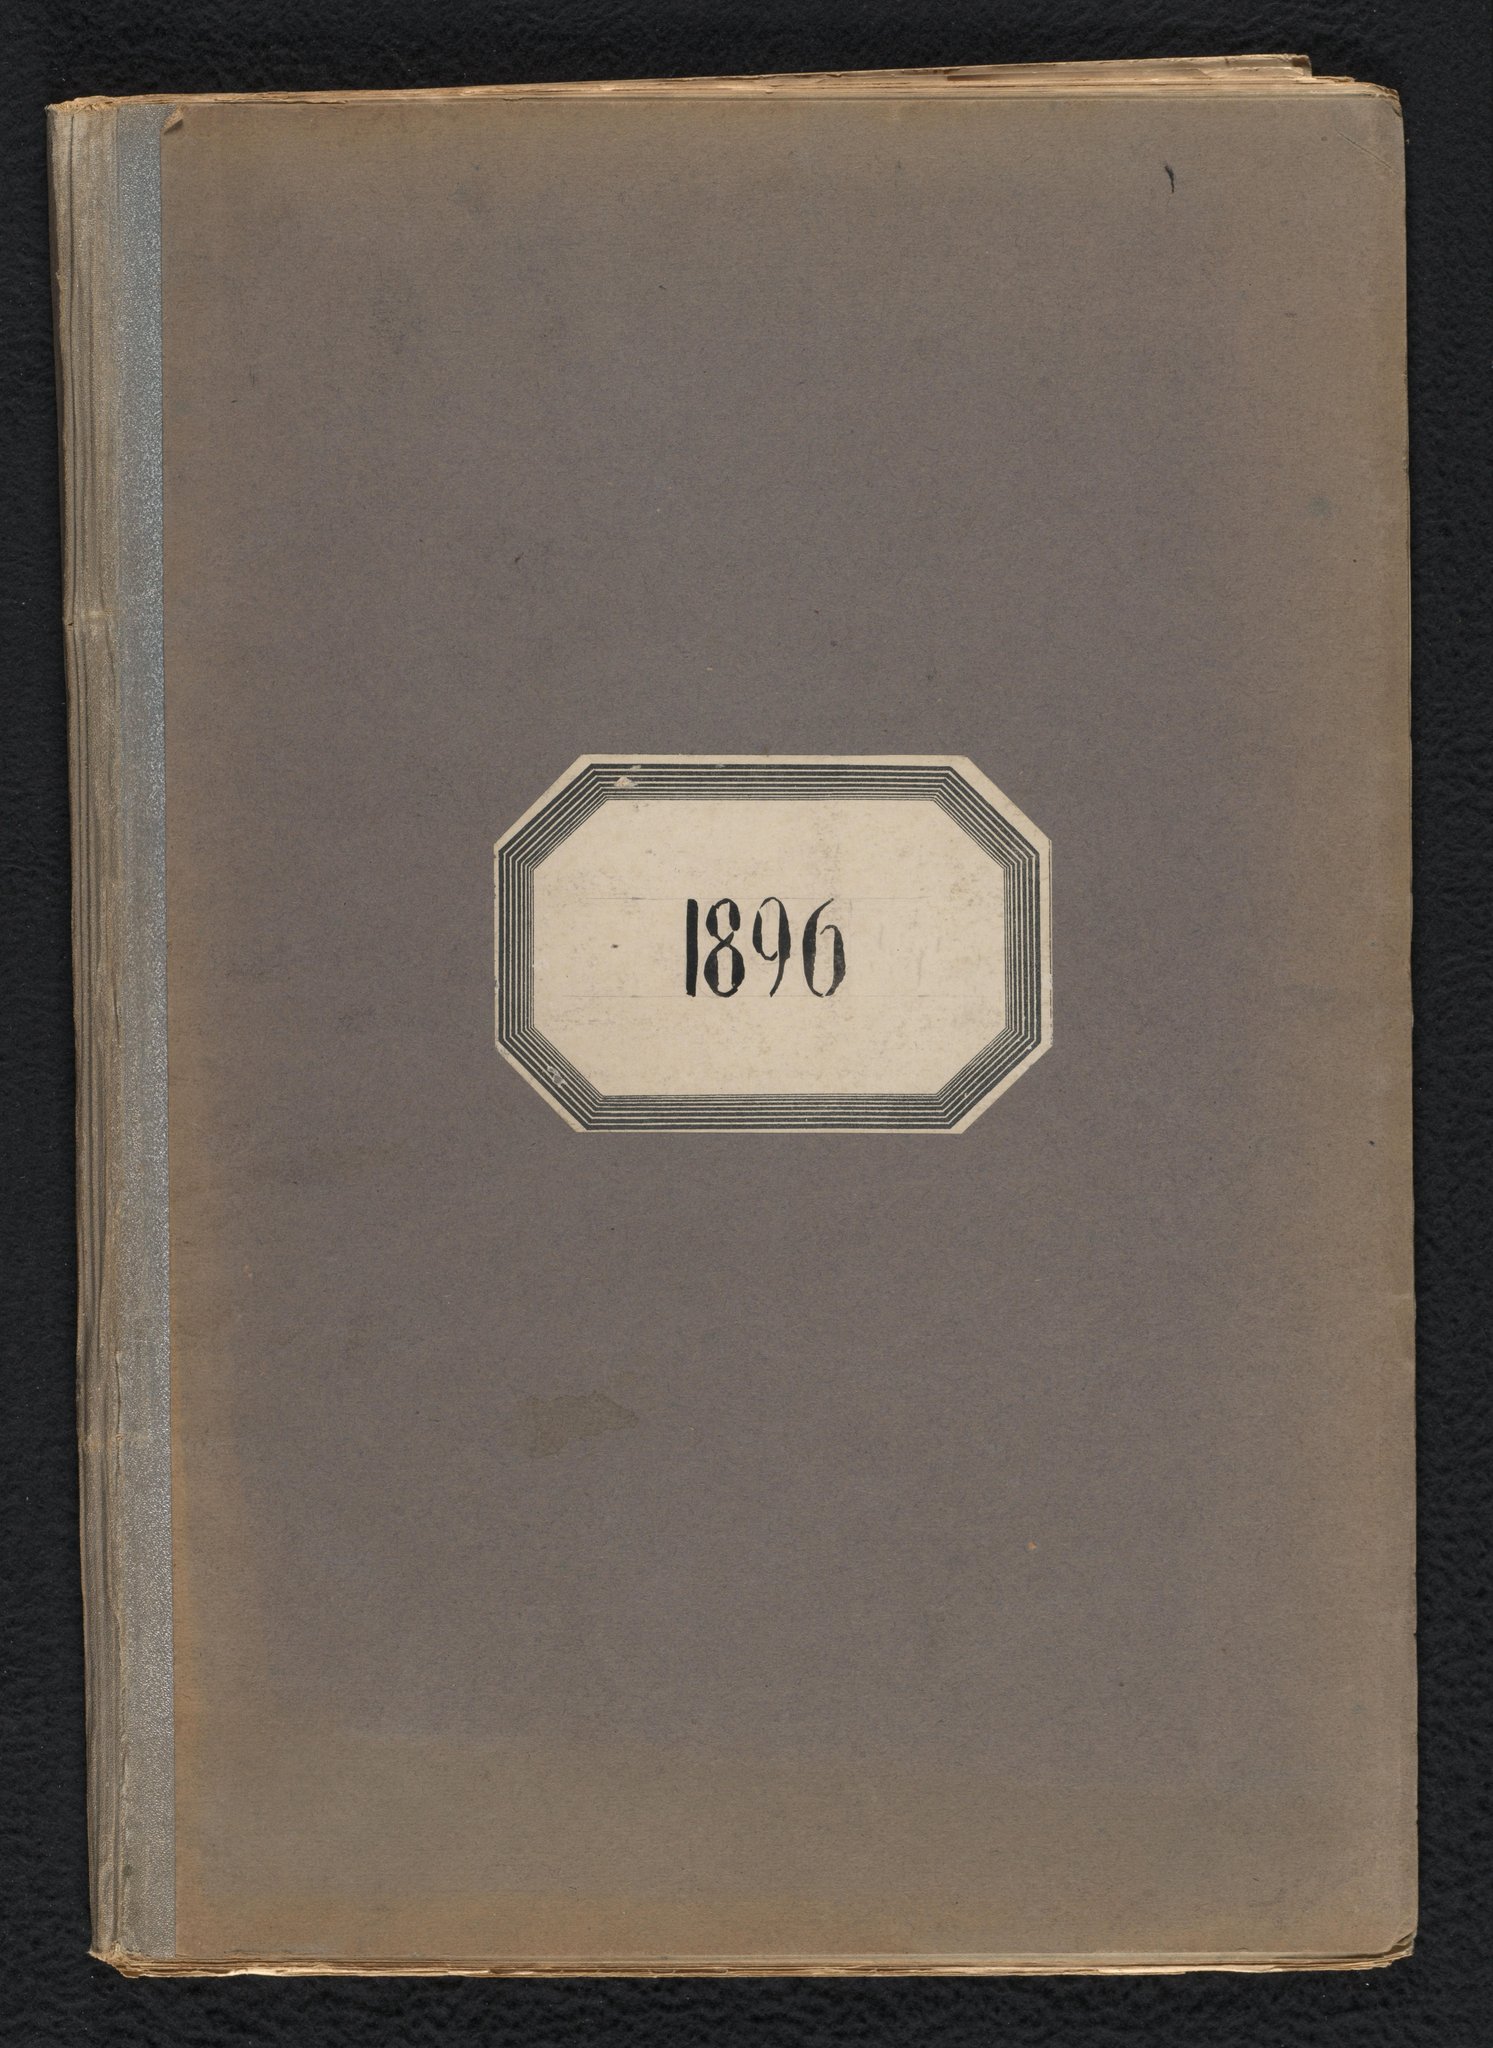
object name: cartoon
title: Spotprenten uit 'De Amsterdammer' van het jaar 1896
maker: johan braakensiek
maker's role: draughtsman, print maker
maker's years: 1858-1940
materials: paper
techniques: lithograph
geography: netherlands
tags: political caricatures and satires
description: Bundel van 61 spotprenten van Braakensiek gepubliceerd als bijvoegsel bij 'De Amsterdammer' in het jaar 1896. Met ook enkele portretten. Bundel geplakt in slappe omslag van grijsgroen karton met handgeschreven etiket '1896'.